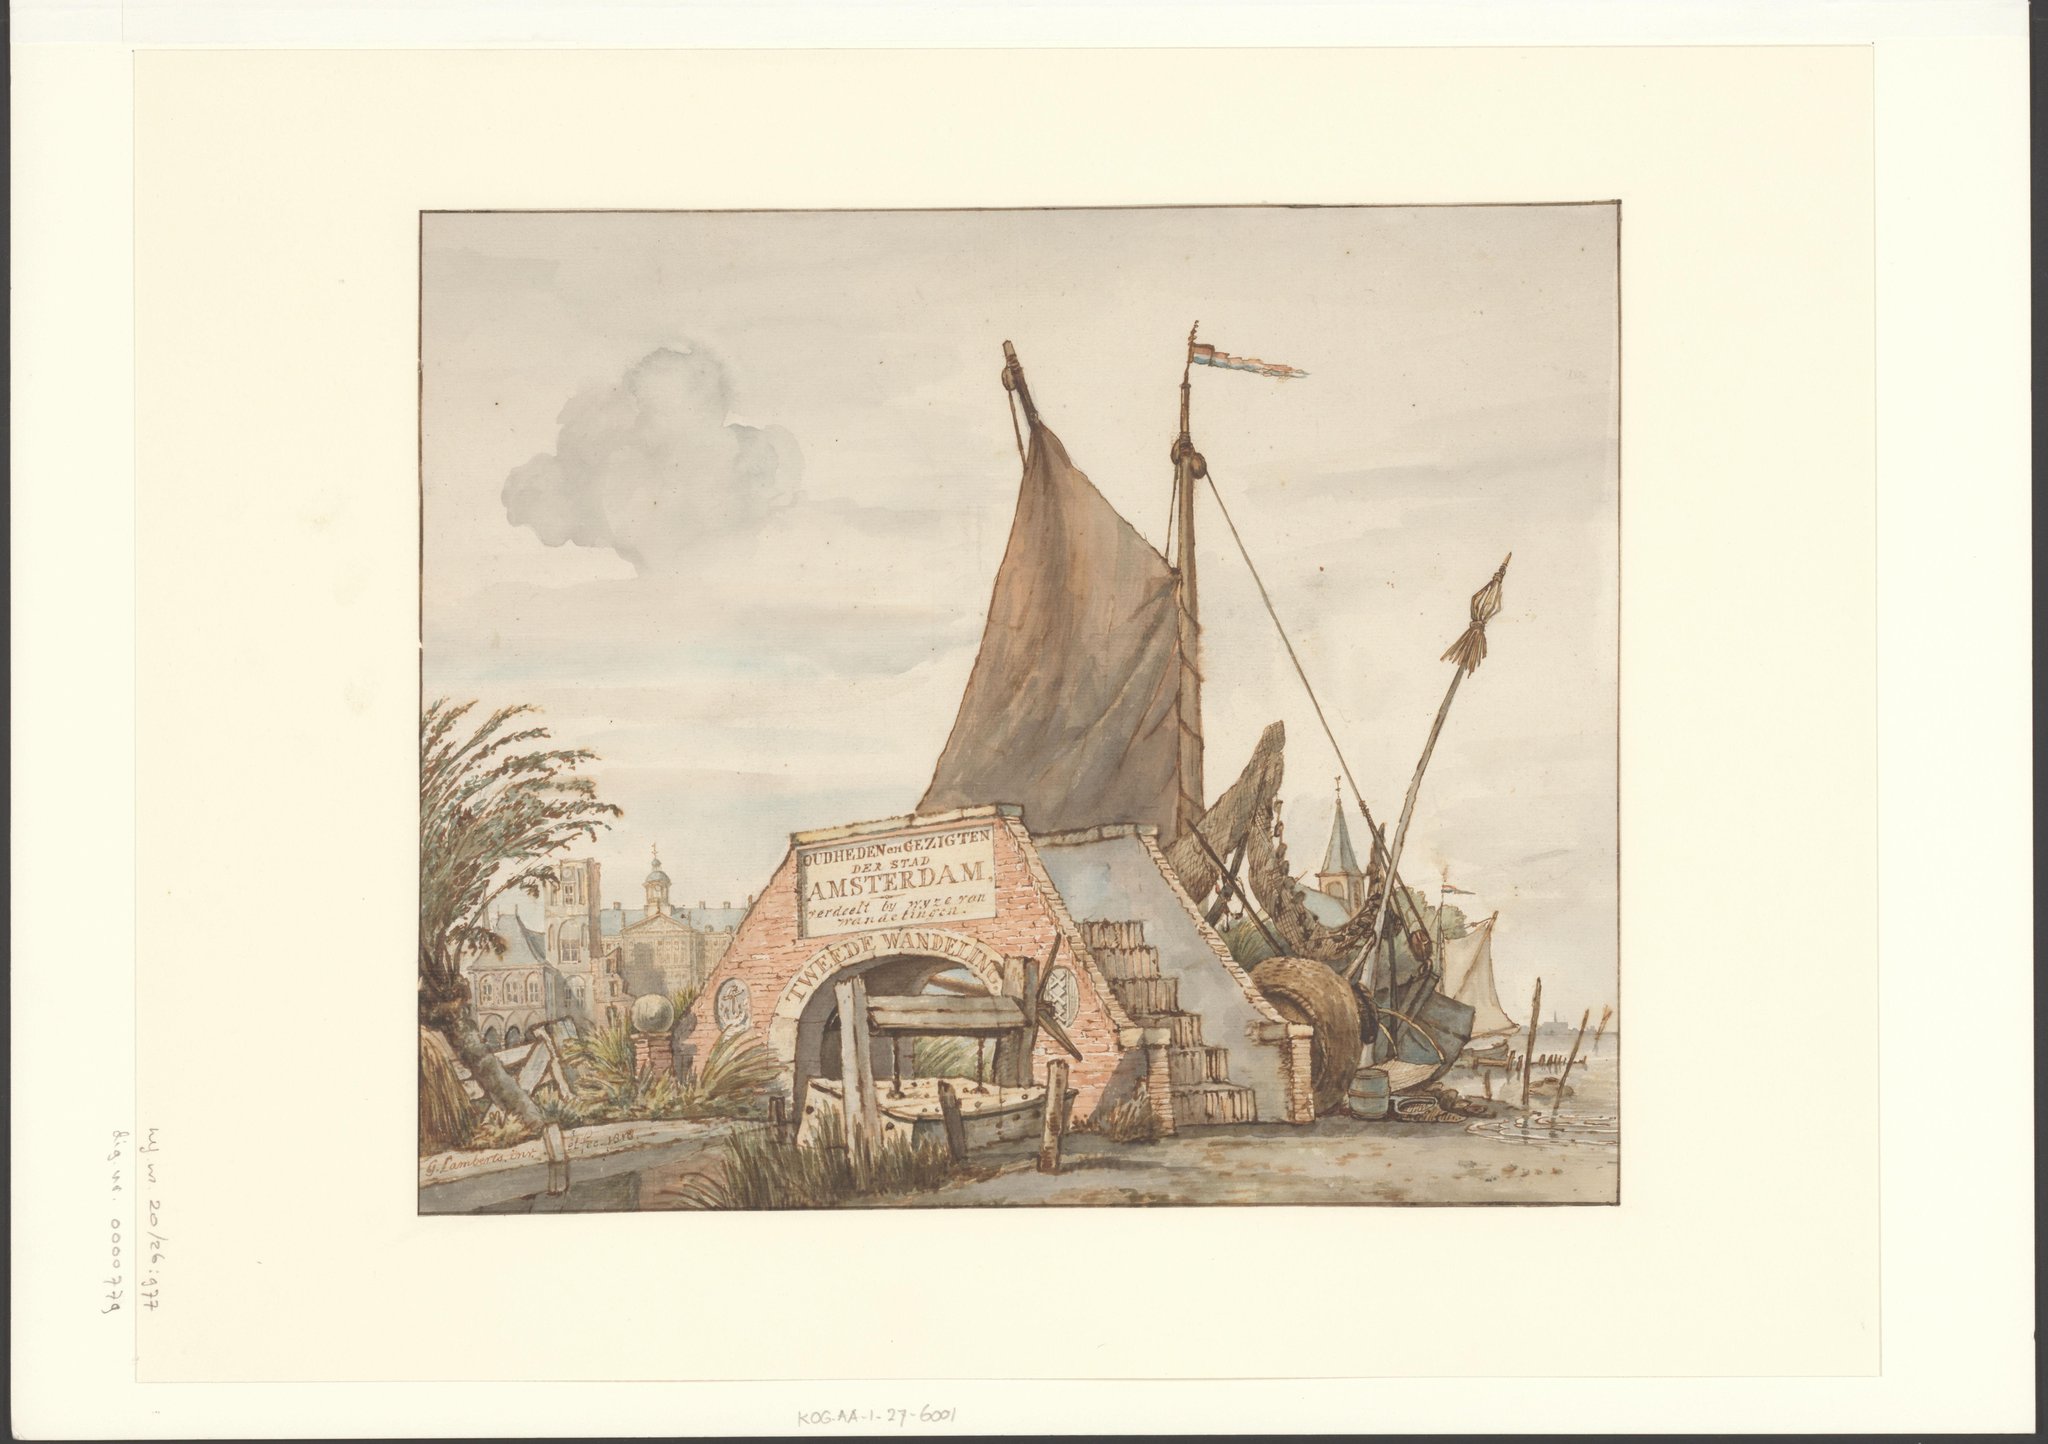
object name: drawing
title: Ontwerp voor een titelpagina voor een Amsterdamse Atlas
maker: gerrit lamberts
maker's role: bookseller, draughtsman, print maker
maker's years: 1776-1850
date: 1818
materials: ink, paper, pencil, watercolor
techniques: brush, pen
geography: amsterdam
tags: city-view in general; 'veduta', canal, townhall, bridge in city across river, canal, etc., amsterdam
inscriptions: signature and date: ‘G.Lamberts. inv. et fec. 1818.’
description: Onderwerpsrubriek binnen de Atlas Amsterdam: Landmacht: Gebouwen / Heinneringen aan officieren, stadssoldaten / Nationale militie / (diverse korpsen) / Padvinders / Parade.